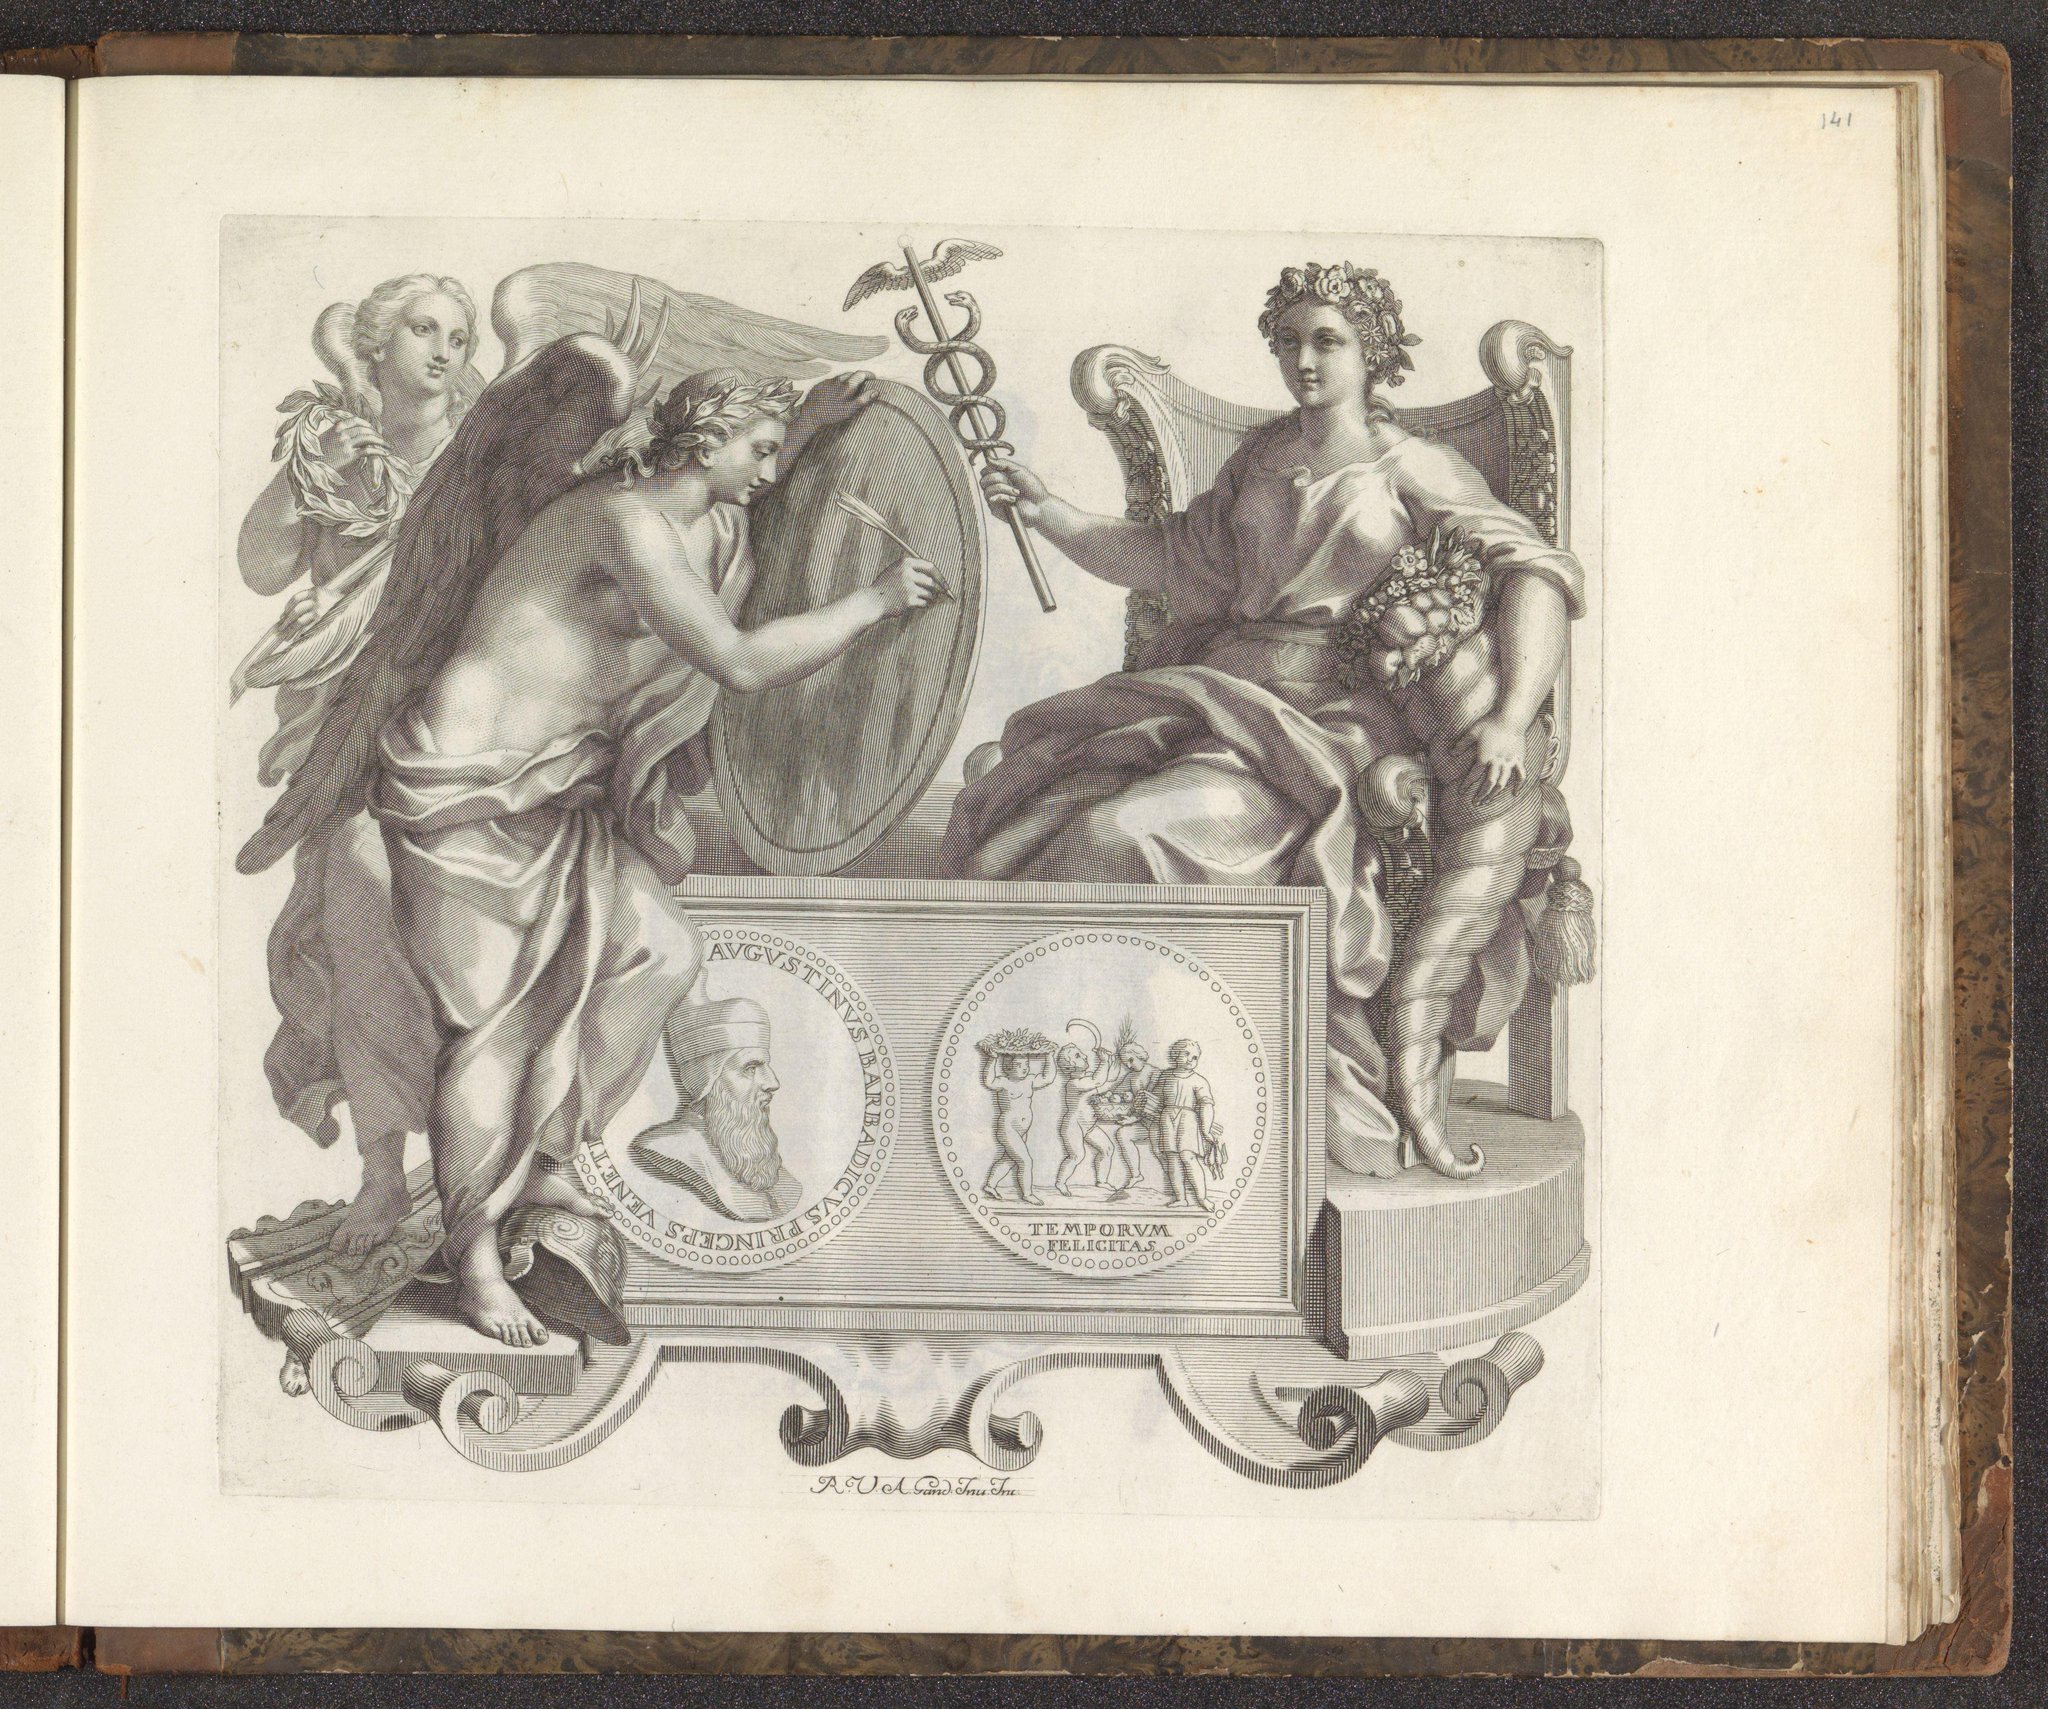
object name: print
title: Portret van Agostino Barbarigo en de personificaties van Scheepsoverwinning, Overwinning en Welvaart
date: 1673-1743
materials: paper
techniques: engraving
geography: rome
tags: 'cornucopia', horn of plenty, medal (considered as a piece of sculpture, regardless of its specific function), 'victoria'; 'vittoria', 'vittoria navale', 'vittoria degl'antichi' (ripa), welfare, prosperity; 'felicità publica', 'prosperità della vita', 'salute' (ripa), caduceus (staff with two snakes, attribute of mercury)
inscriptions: collector's mark: Lugt 2228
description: Voetstuk in de vorm van een cartouche. Daarop een medaillon met op de voorzijde het portret van Agostino Barbarigo met dogehoed. Op de achterkant vier kinderen met jachtbuit, korenaren en schalen met bloemen en fruit. Daarbij de tekst: Temporum Felicitas. Het voetstuk wordt omringd door drie personificaties. Geheel links staat Overwinning op zee: een vrouw met lauwerkrans en palmtak, staande op een scheepsboeg. Daarnaast schrijft Overwinning op een schild. Haar linkervoet staat op een helm. Rechts zit Welvaart of Gelukzaligheid op een troon. In haar handen een slangenstaf en hoorn des overvloeds. Op haar hoofd een bloemenkrans. De prent maakt deel uit van een album.